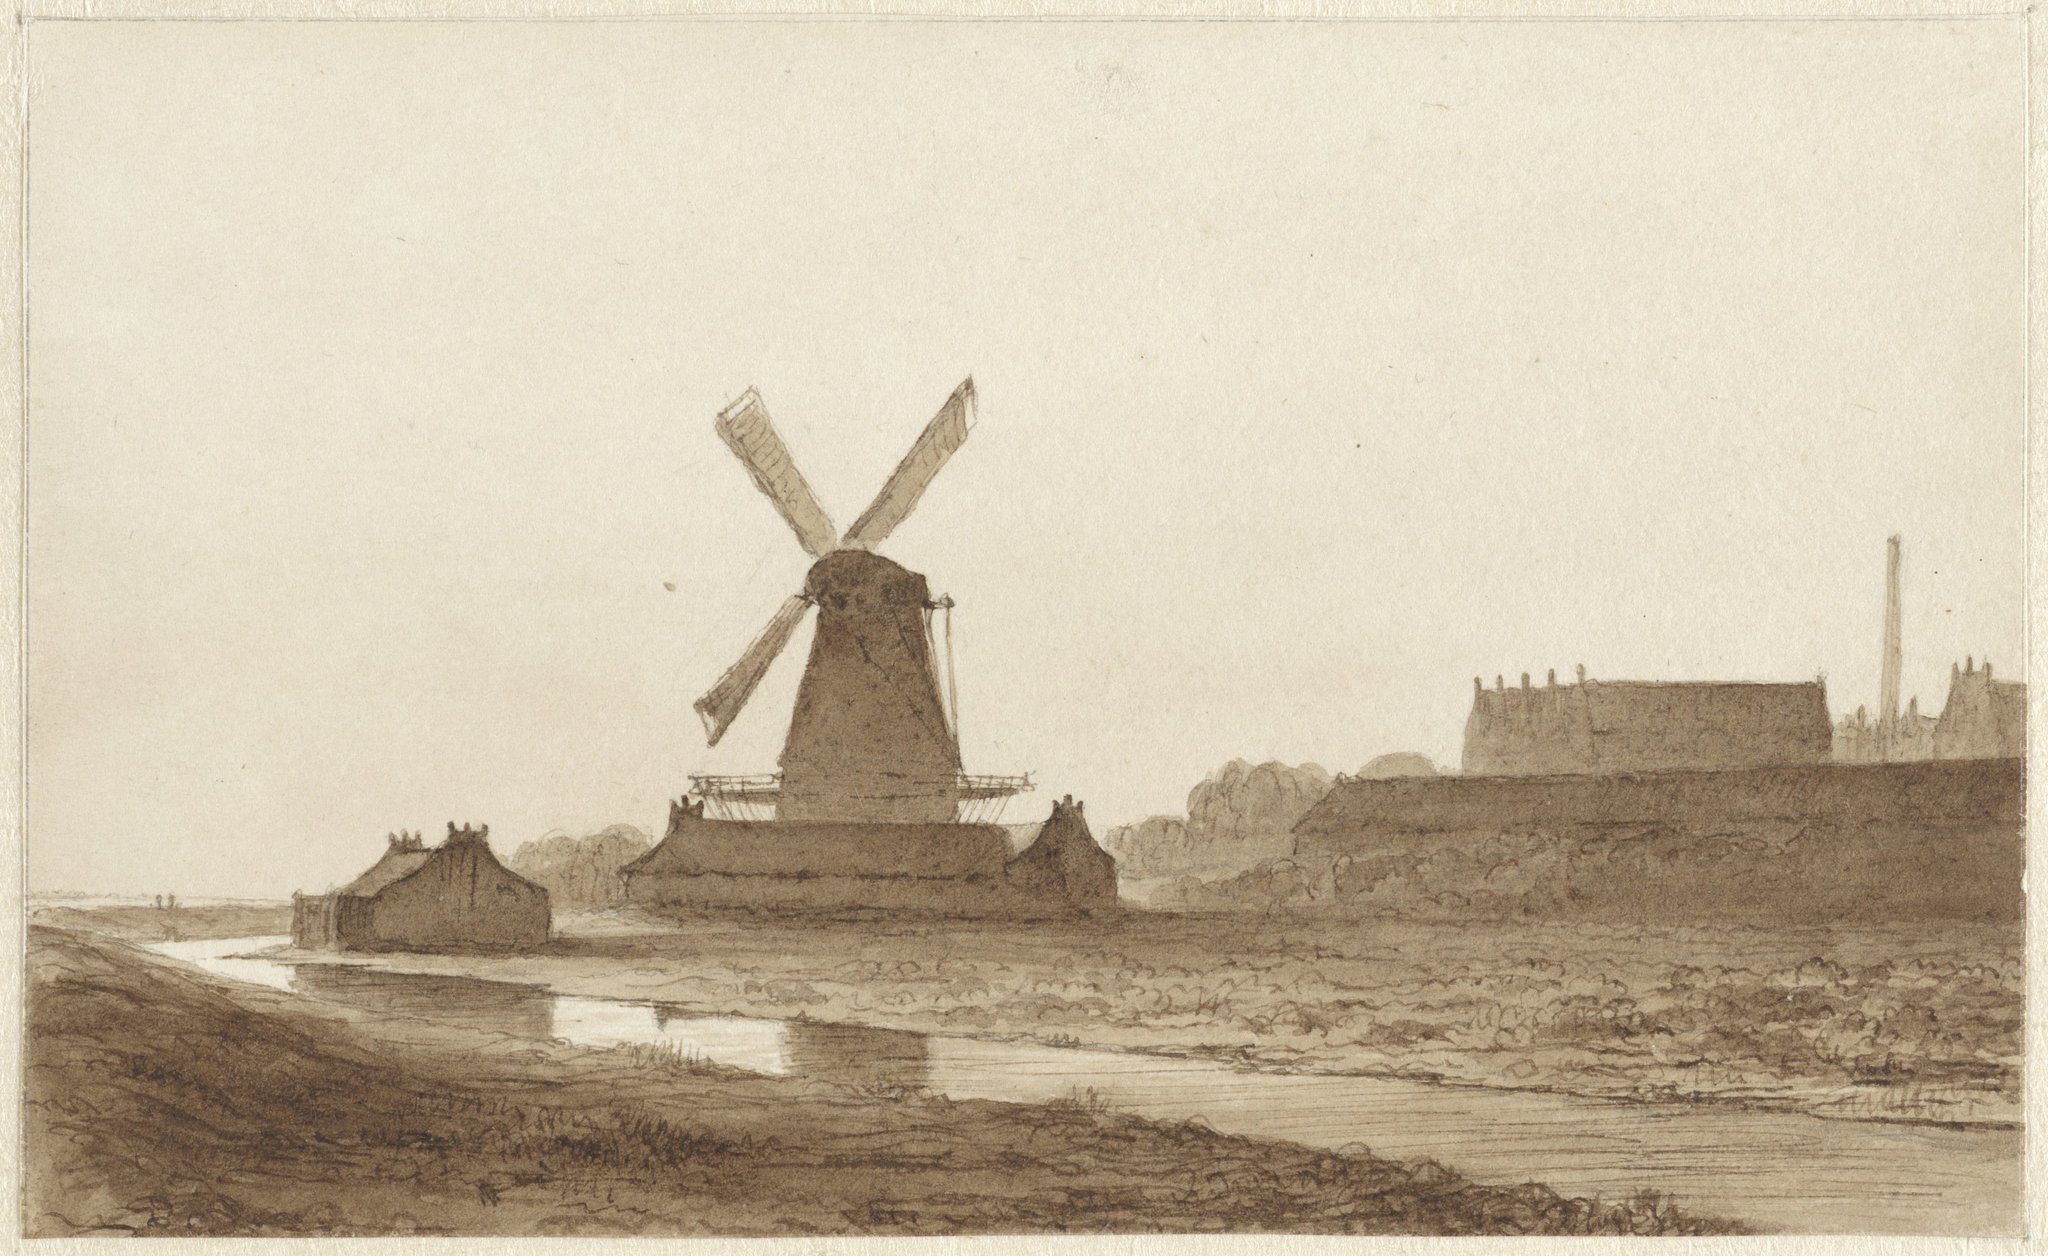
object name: drawing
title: Molen bij het bolwerk Het Blauwhoofd te Amsterdam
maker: hendrik abraham klinkhamer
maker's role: draughtsman, painter, print maker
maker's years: 1810-1872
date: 1853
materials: ink, paper, pencil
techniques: brush, pen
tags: factories and mills in landscape, bastion, bulwark, amsterdam